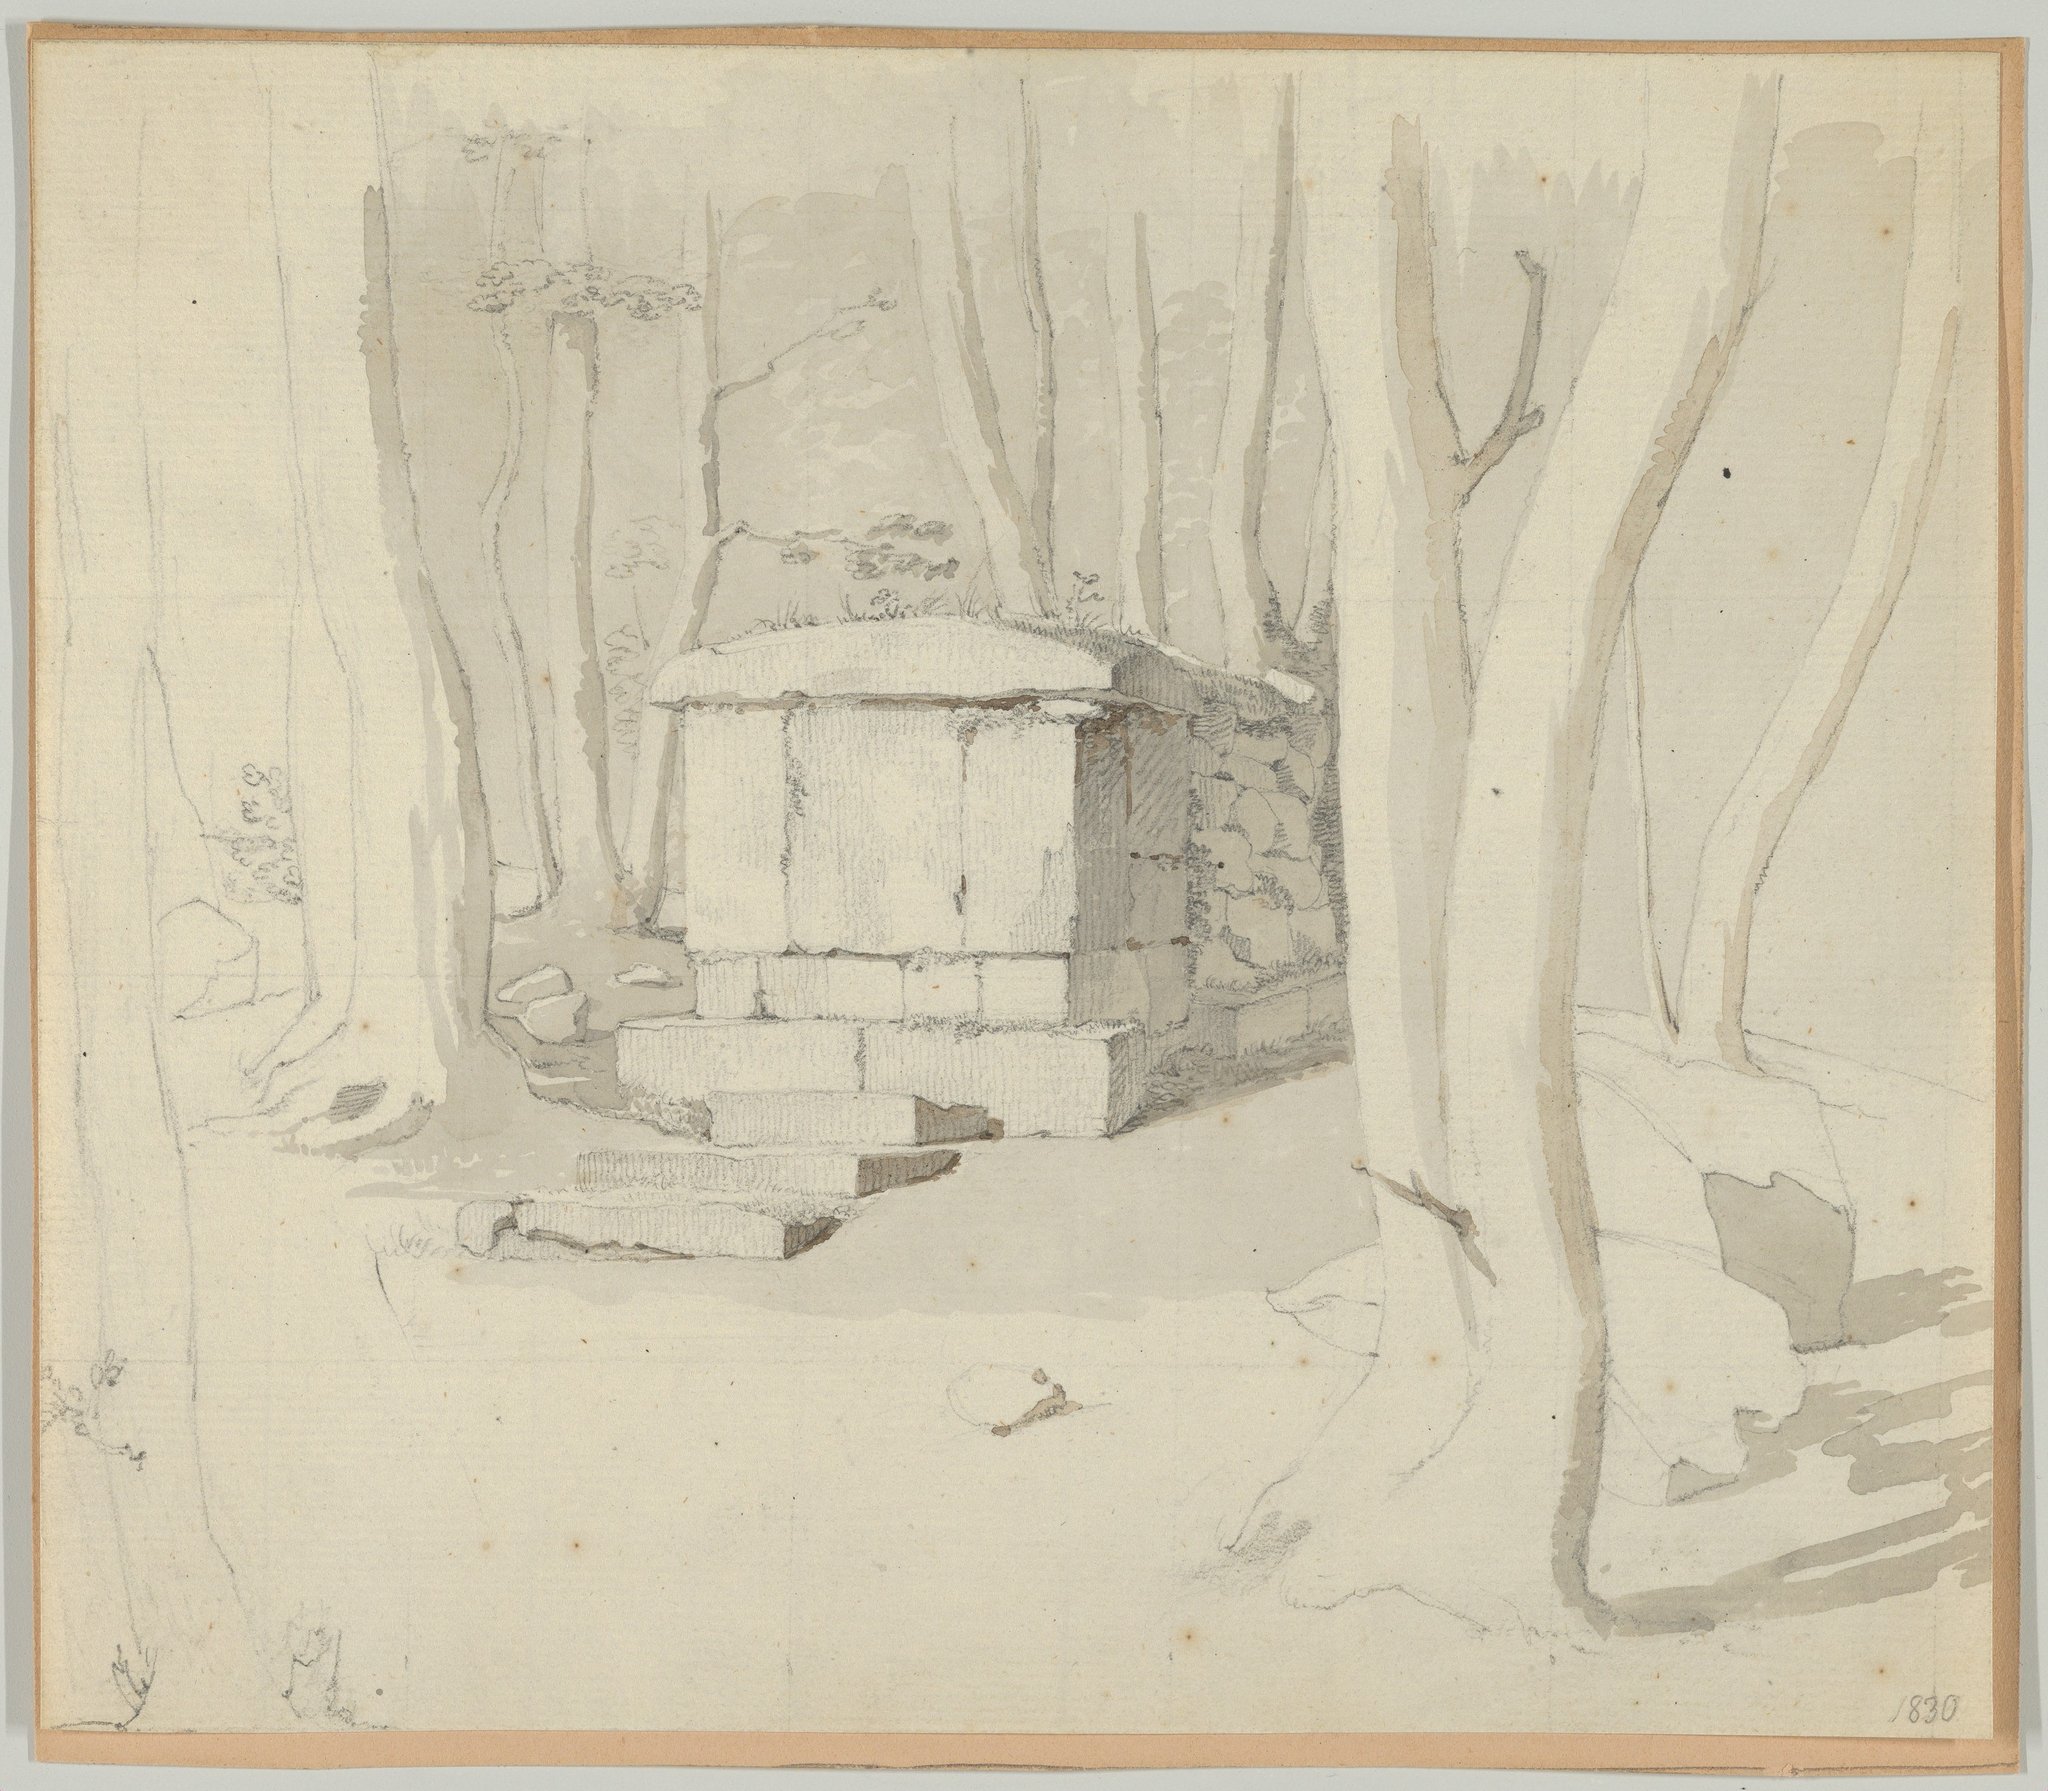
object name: drawing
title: A Stone Tomb in a Forest; verso: Study of a Flower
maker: christen købke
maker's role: artist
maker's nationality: danish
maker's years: 1810-1848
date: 1830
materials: graphite, ink, watercolor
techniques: brush, pen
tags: tombs,trees